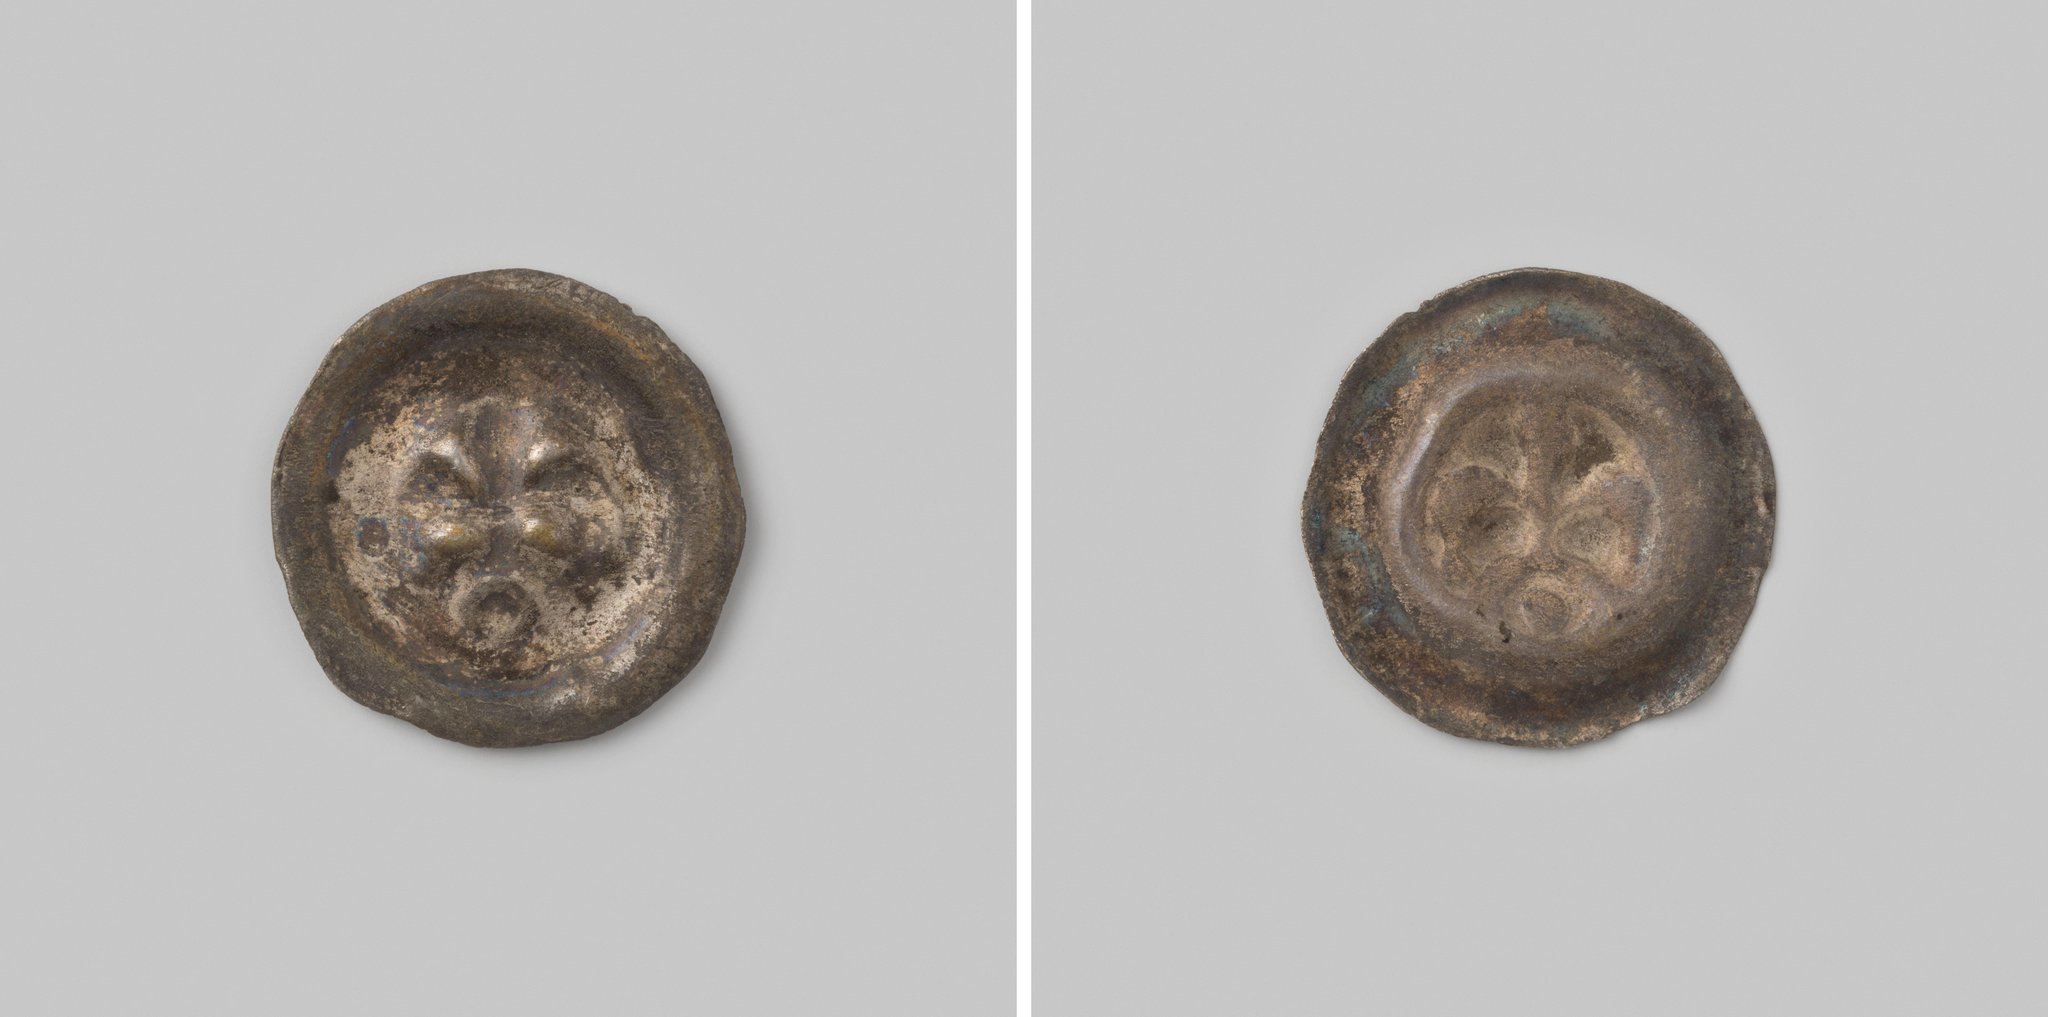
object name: coin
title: Stad Demmin, Pommeren, brakteaat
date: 1200-1300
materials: silver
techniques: striking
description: Zilveren munt. Voorzijde: lelie, wapen van de stad. Keerzijde: blanco, eenzijdig geslagen.